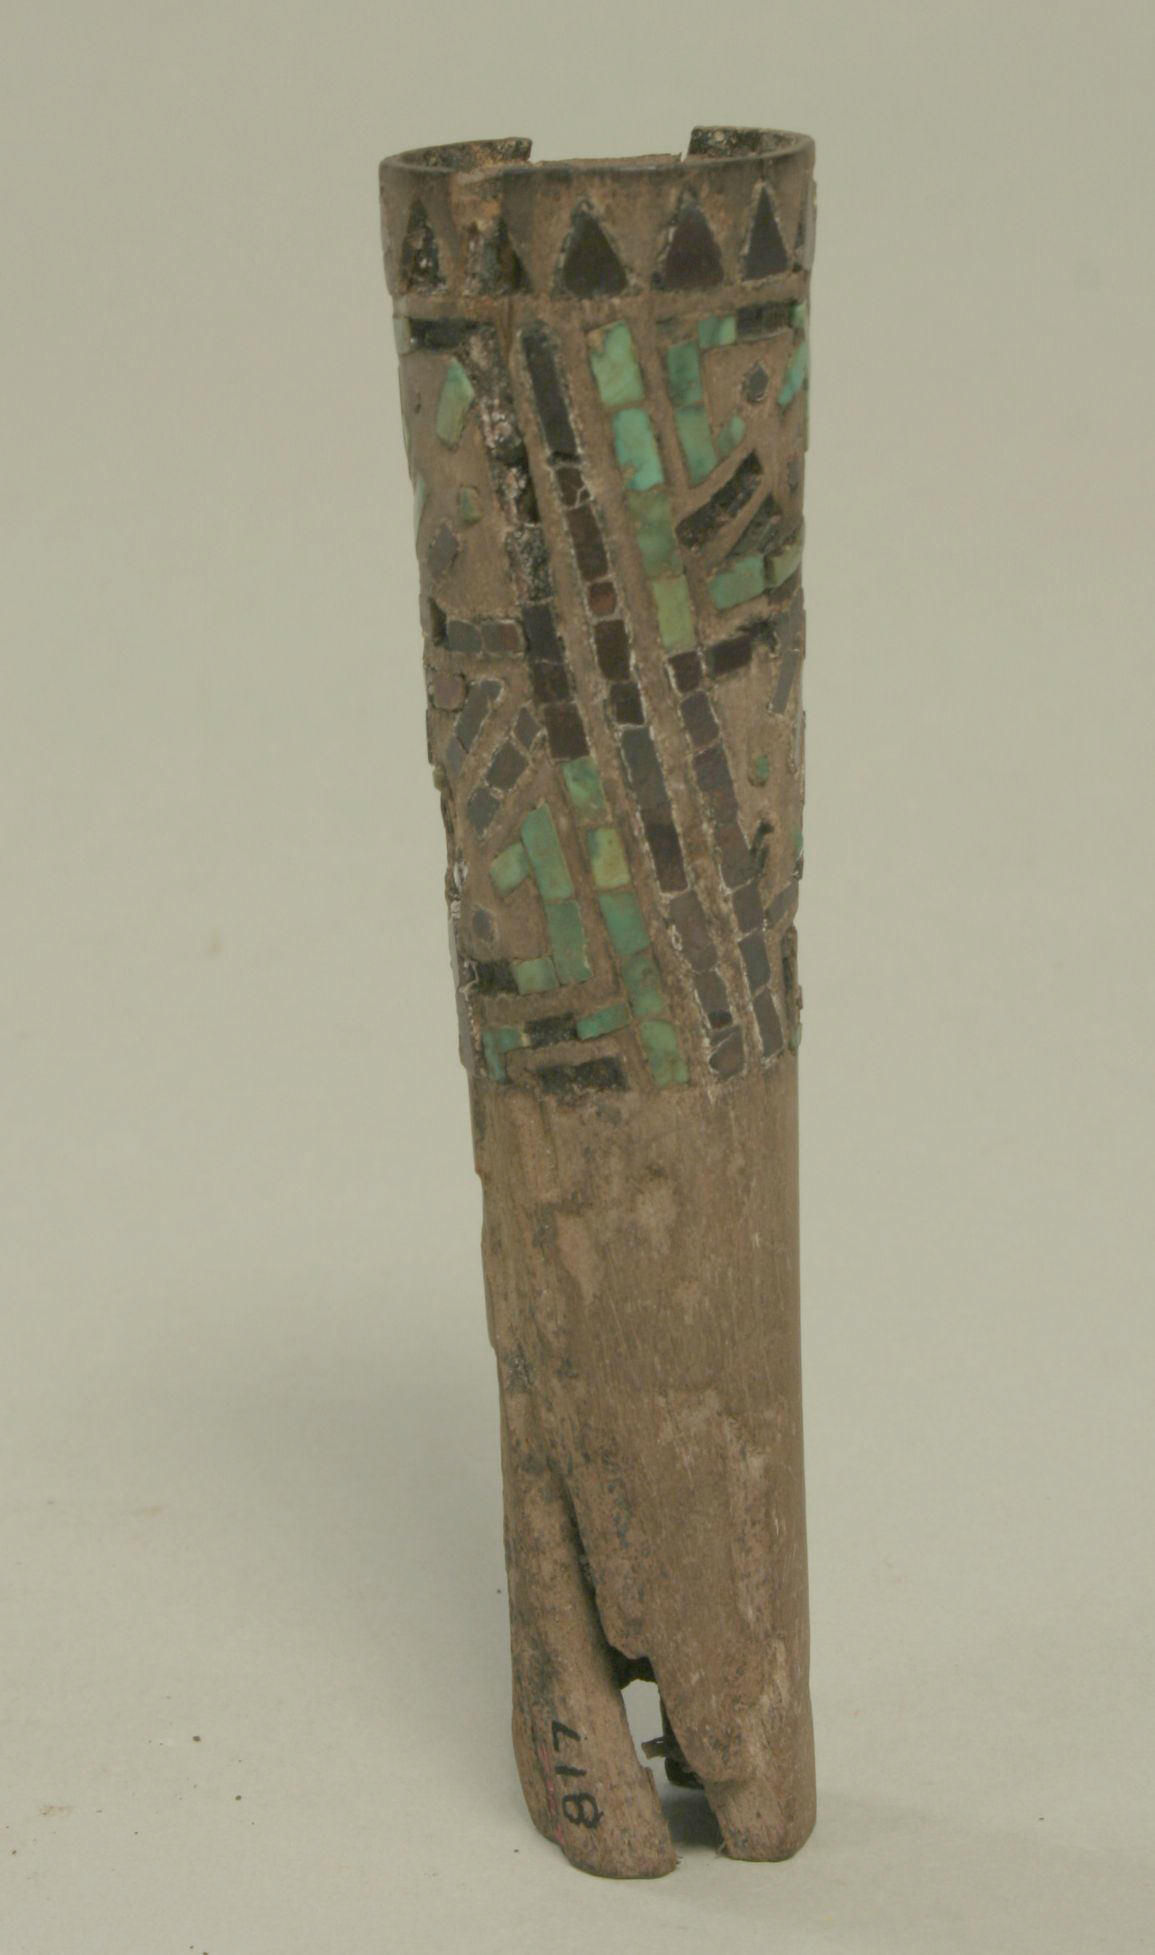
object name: earflare fragment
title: Earflare Fragment with Stone Inlay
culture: peruvian, north or central coast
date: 701-1566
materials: stone, wood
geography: peru